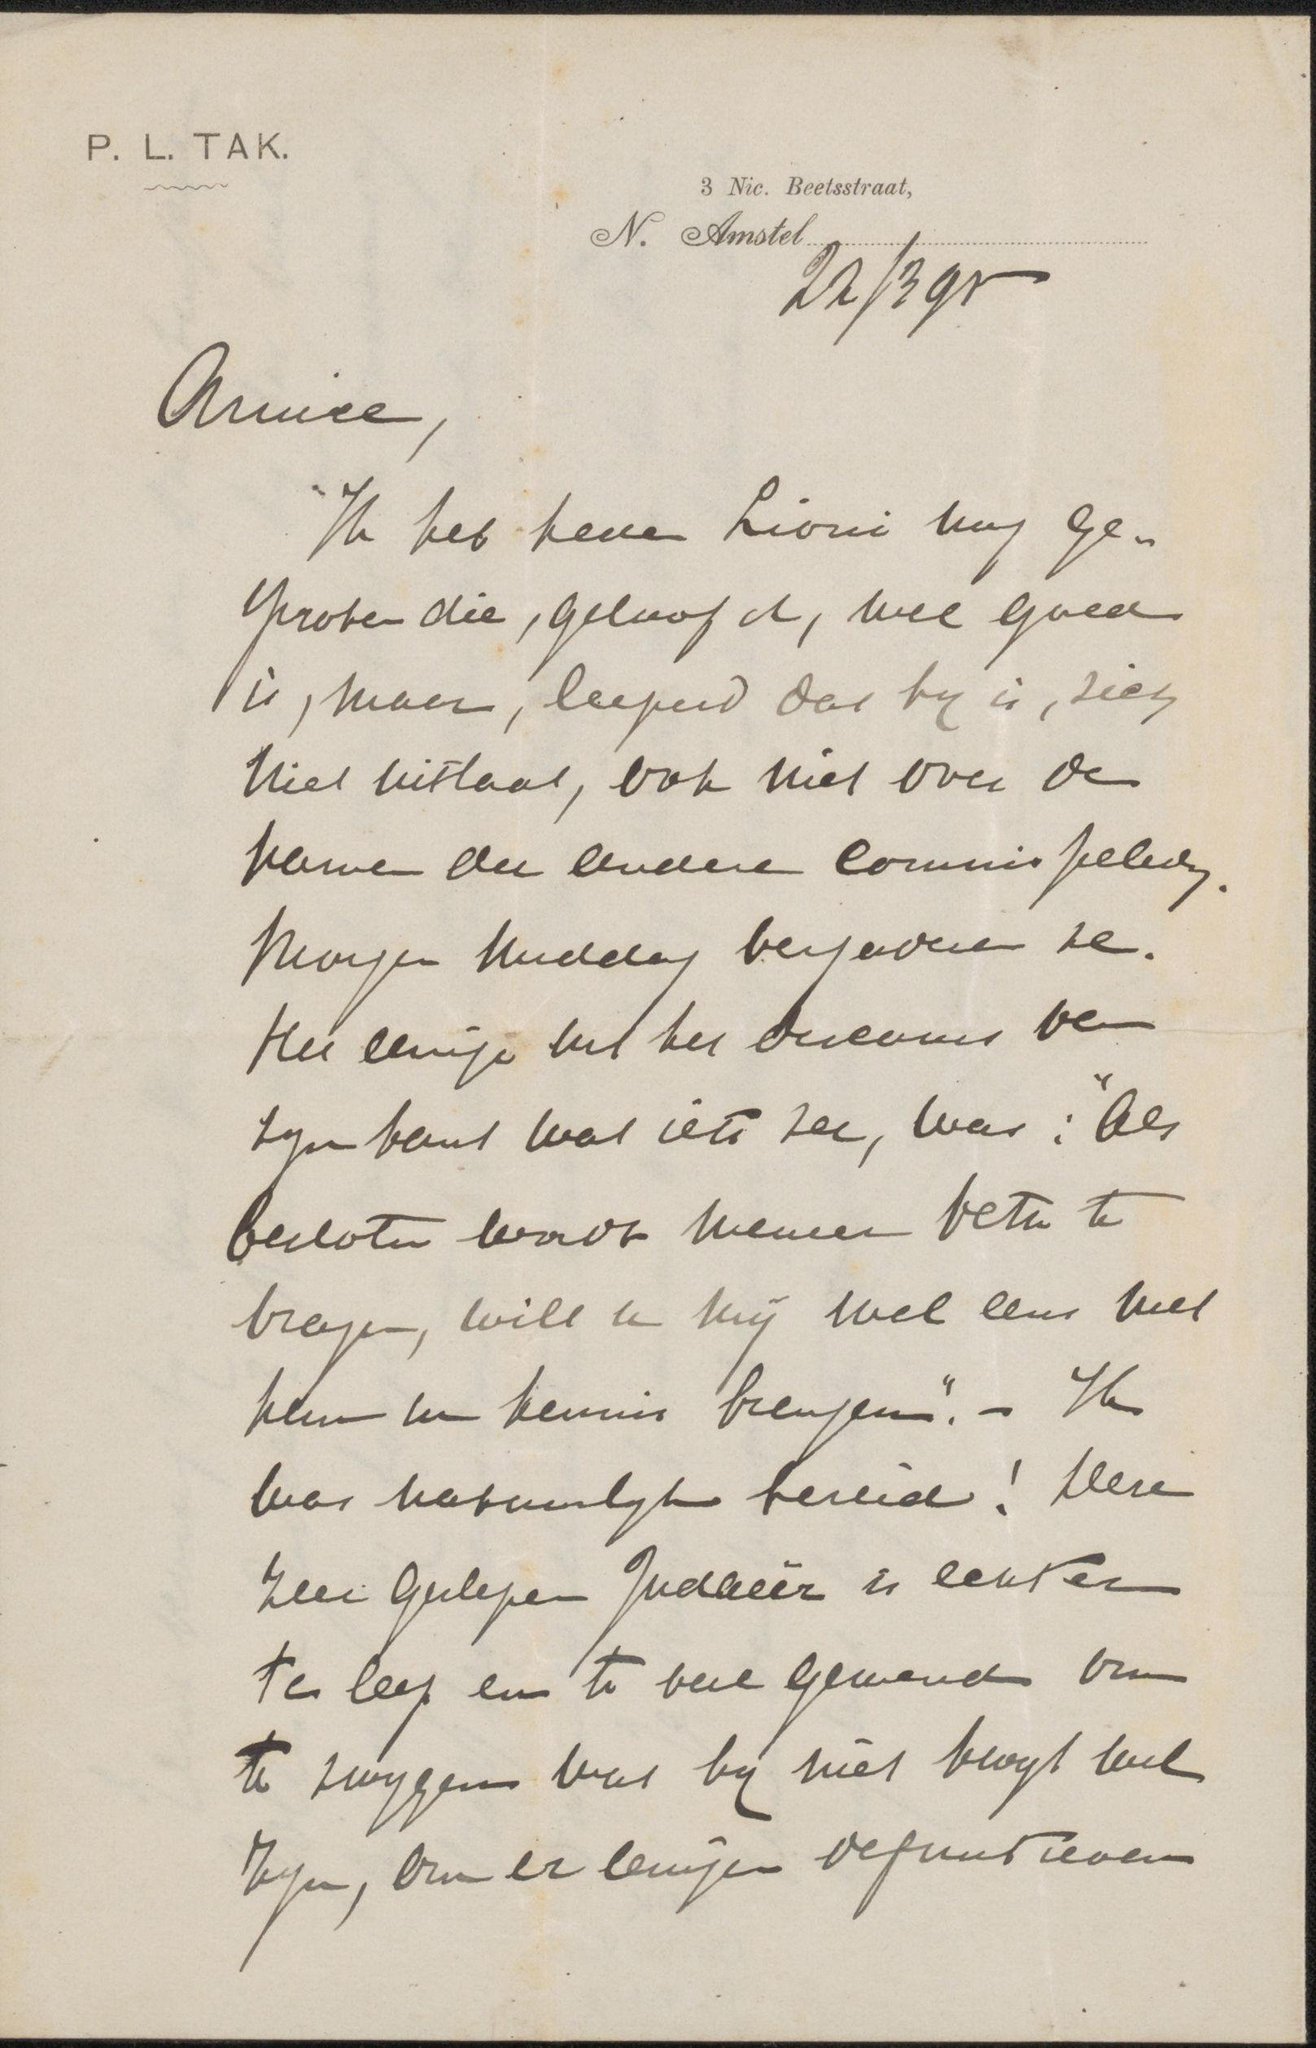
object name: letter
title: Brief aan Jan Veth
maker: pieter lodewijk tak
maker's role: politician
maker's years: 1848-1907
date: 1895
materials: ink, paper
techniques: pen, printing, writing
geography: nieuwer-amstel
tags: amsterdam, painter, draughtsman, designer, jan veth, marius bauer, publisher, albert sijthoff, the graphic arts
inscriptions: watermark, collector's mark: ‘RPK’